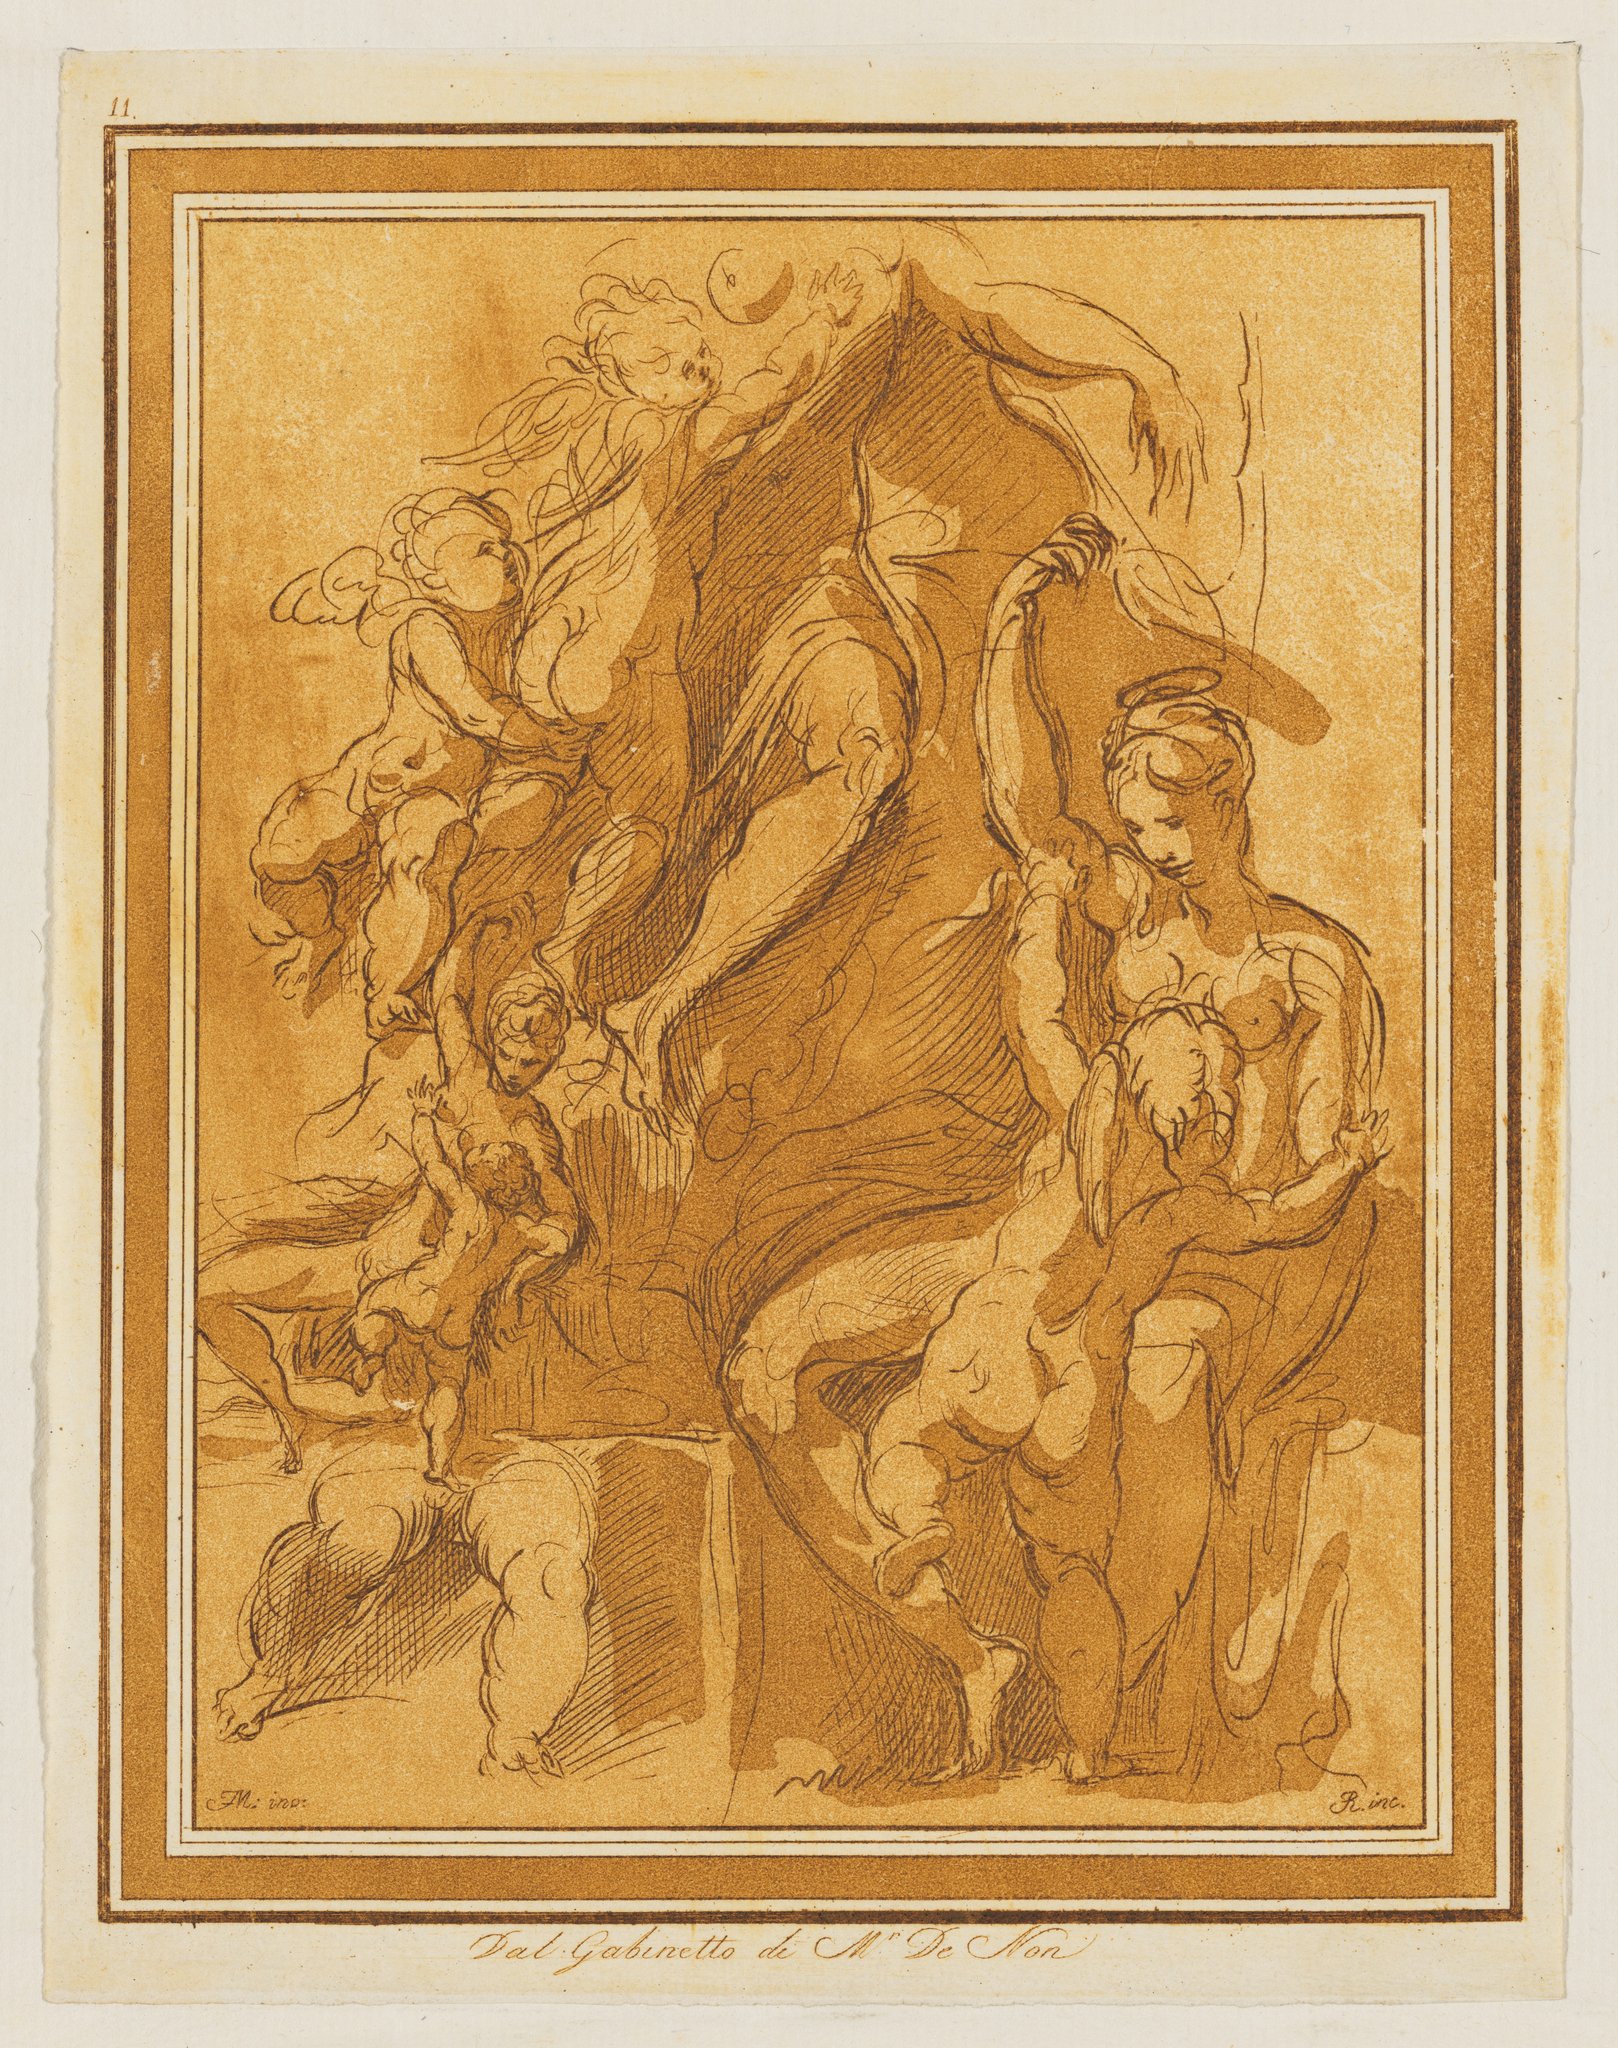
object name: print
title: Study of Venus and Cupid, from Prove di Vari Rami Inediti [...]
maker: francesco rosaspina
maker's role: artist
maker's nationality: italian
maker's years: 1762-1841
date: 1801-1900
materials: ink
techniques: aquatint, etching